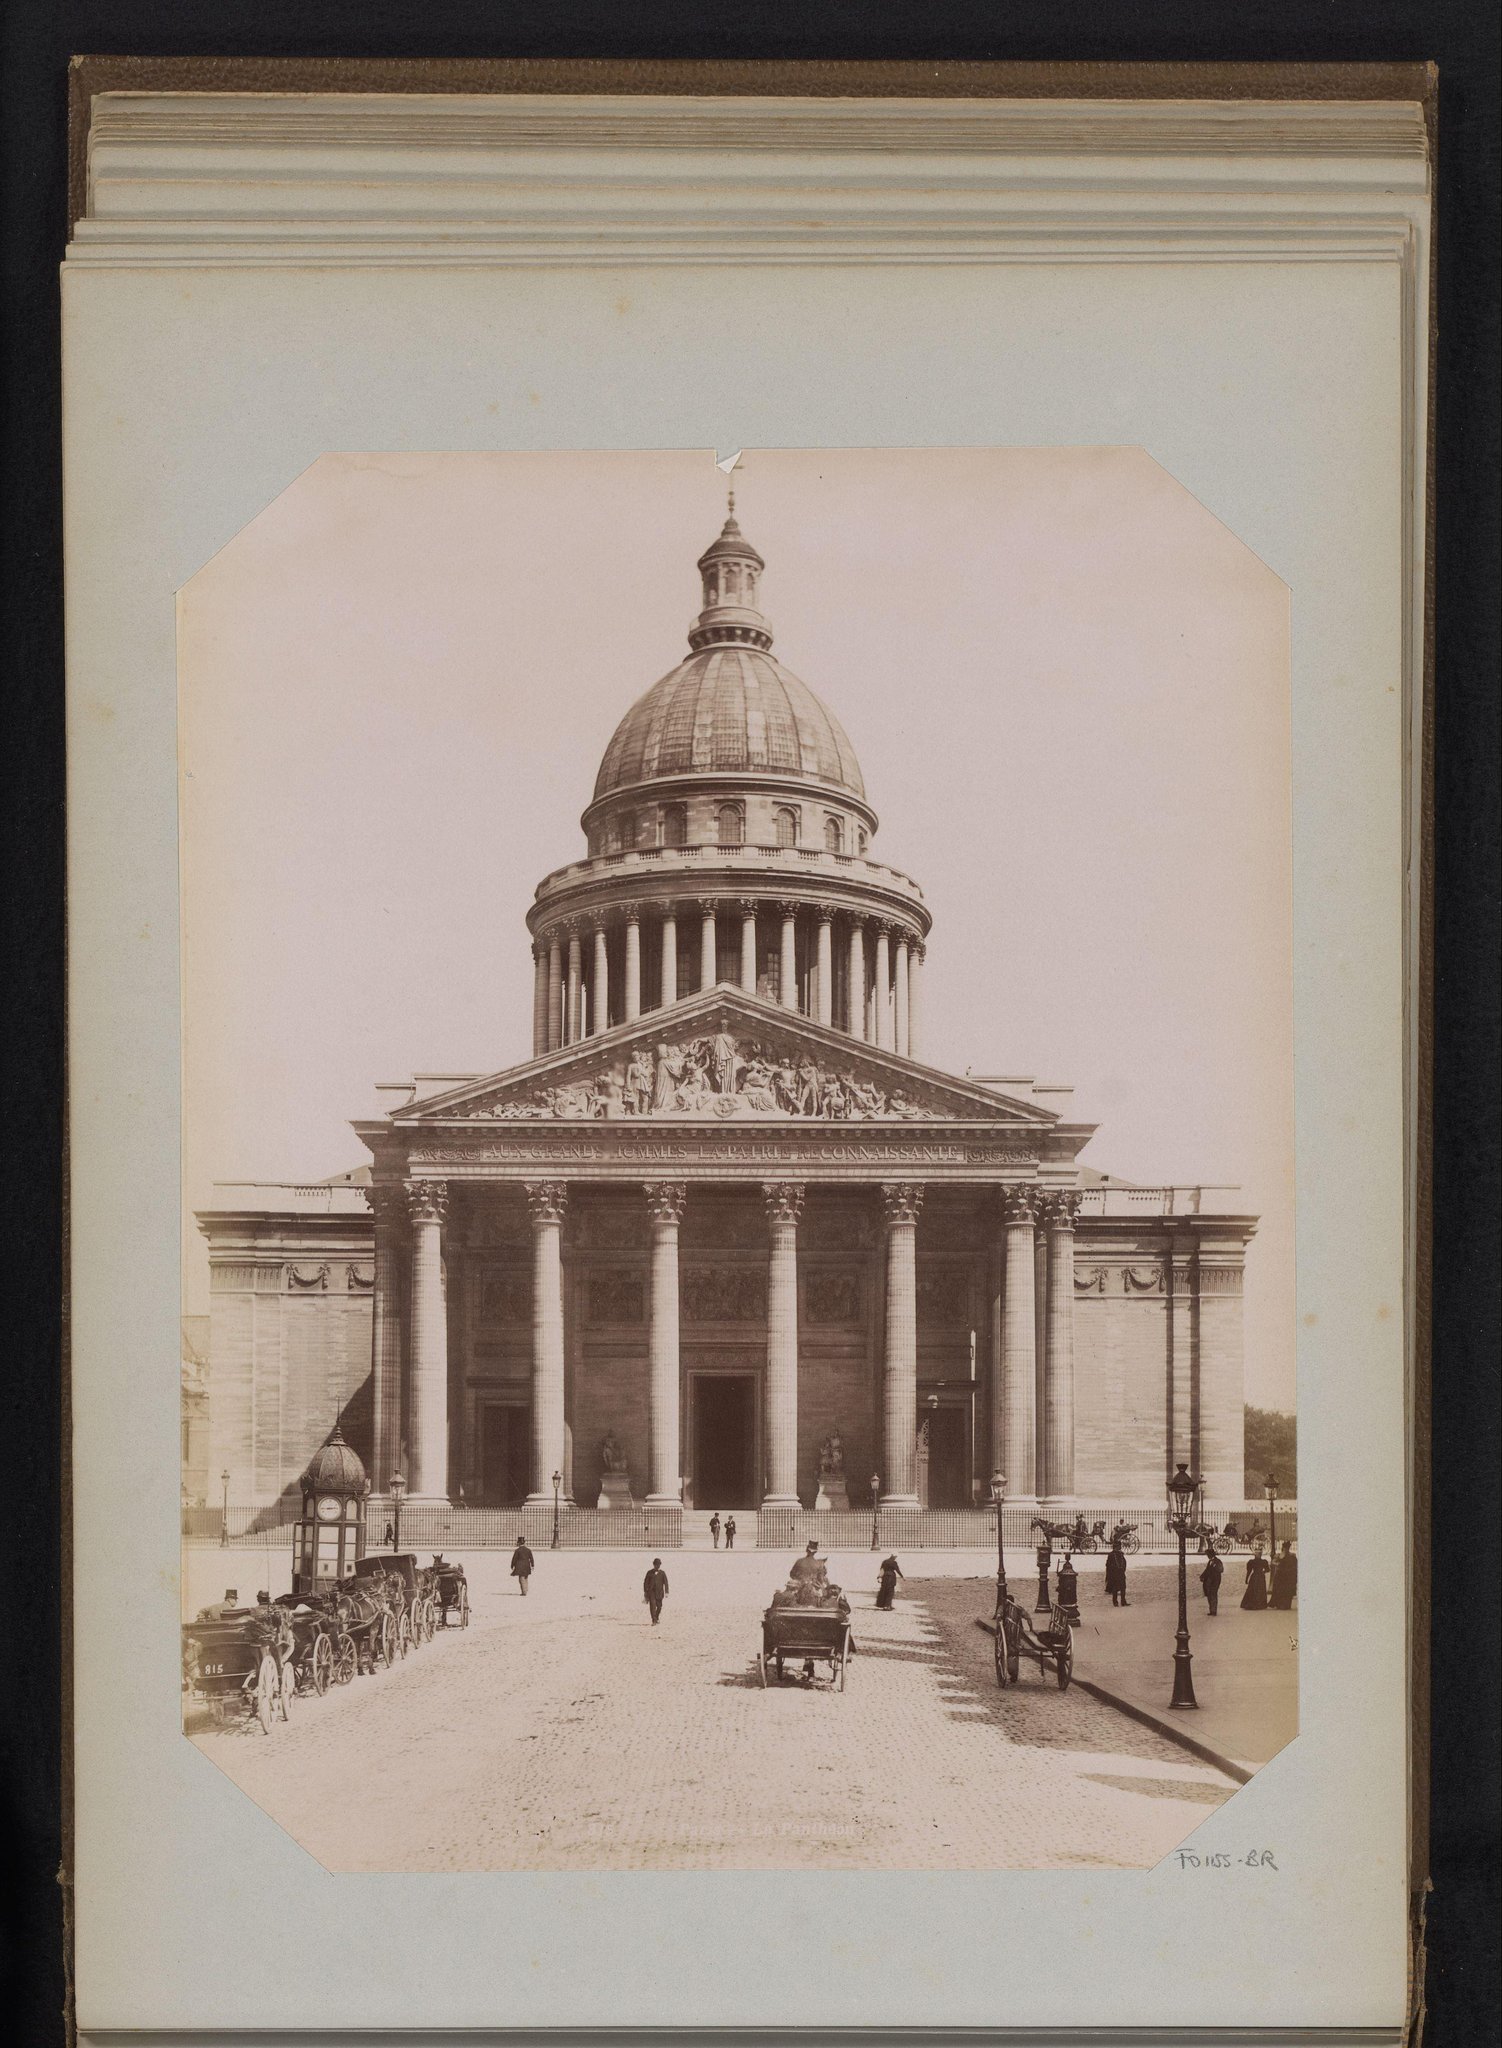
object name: photograph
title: Gezicht op het Panthéon te Parijs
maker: Anonymous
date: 1890-1898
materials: photographic support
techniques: albumen print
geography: paris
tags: church (exterior), grave-building, monumental tomb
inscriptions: retailer's mark: ‘E. Hautecoeur/ Estampes Photographies/ 35 Avenue de l'Opéra, 35/ Paris’, inscription: ‘815. Paris - Le Panthéon’